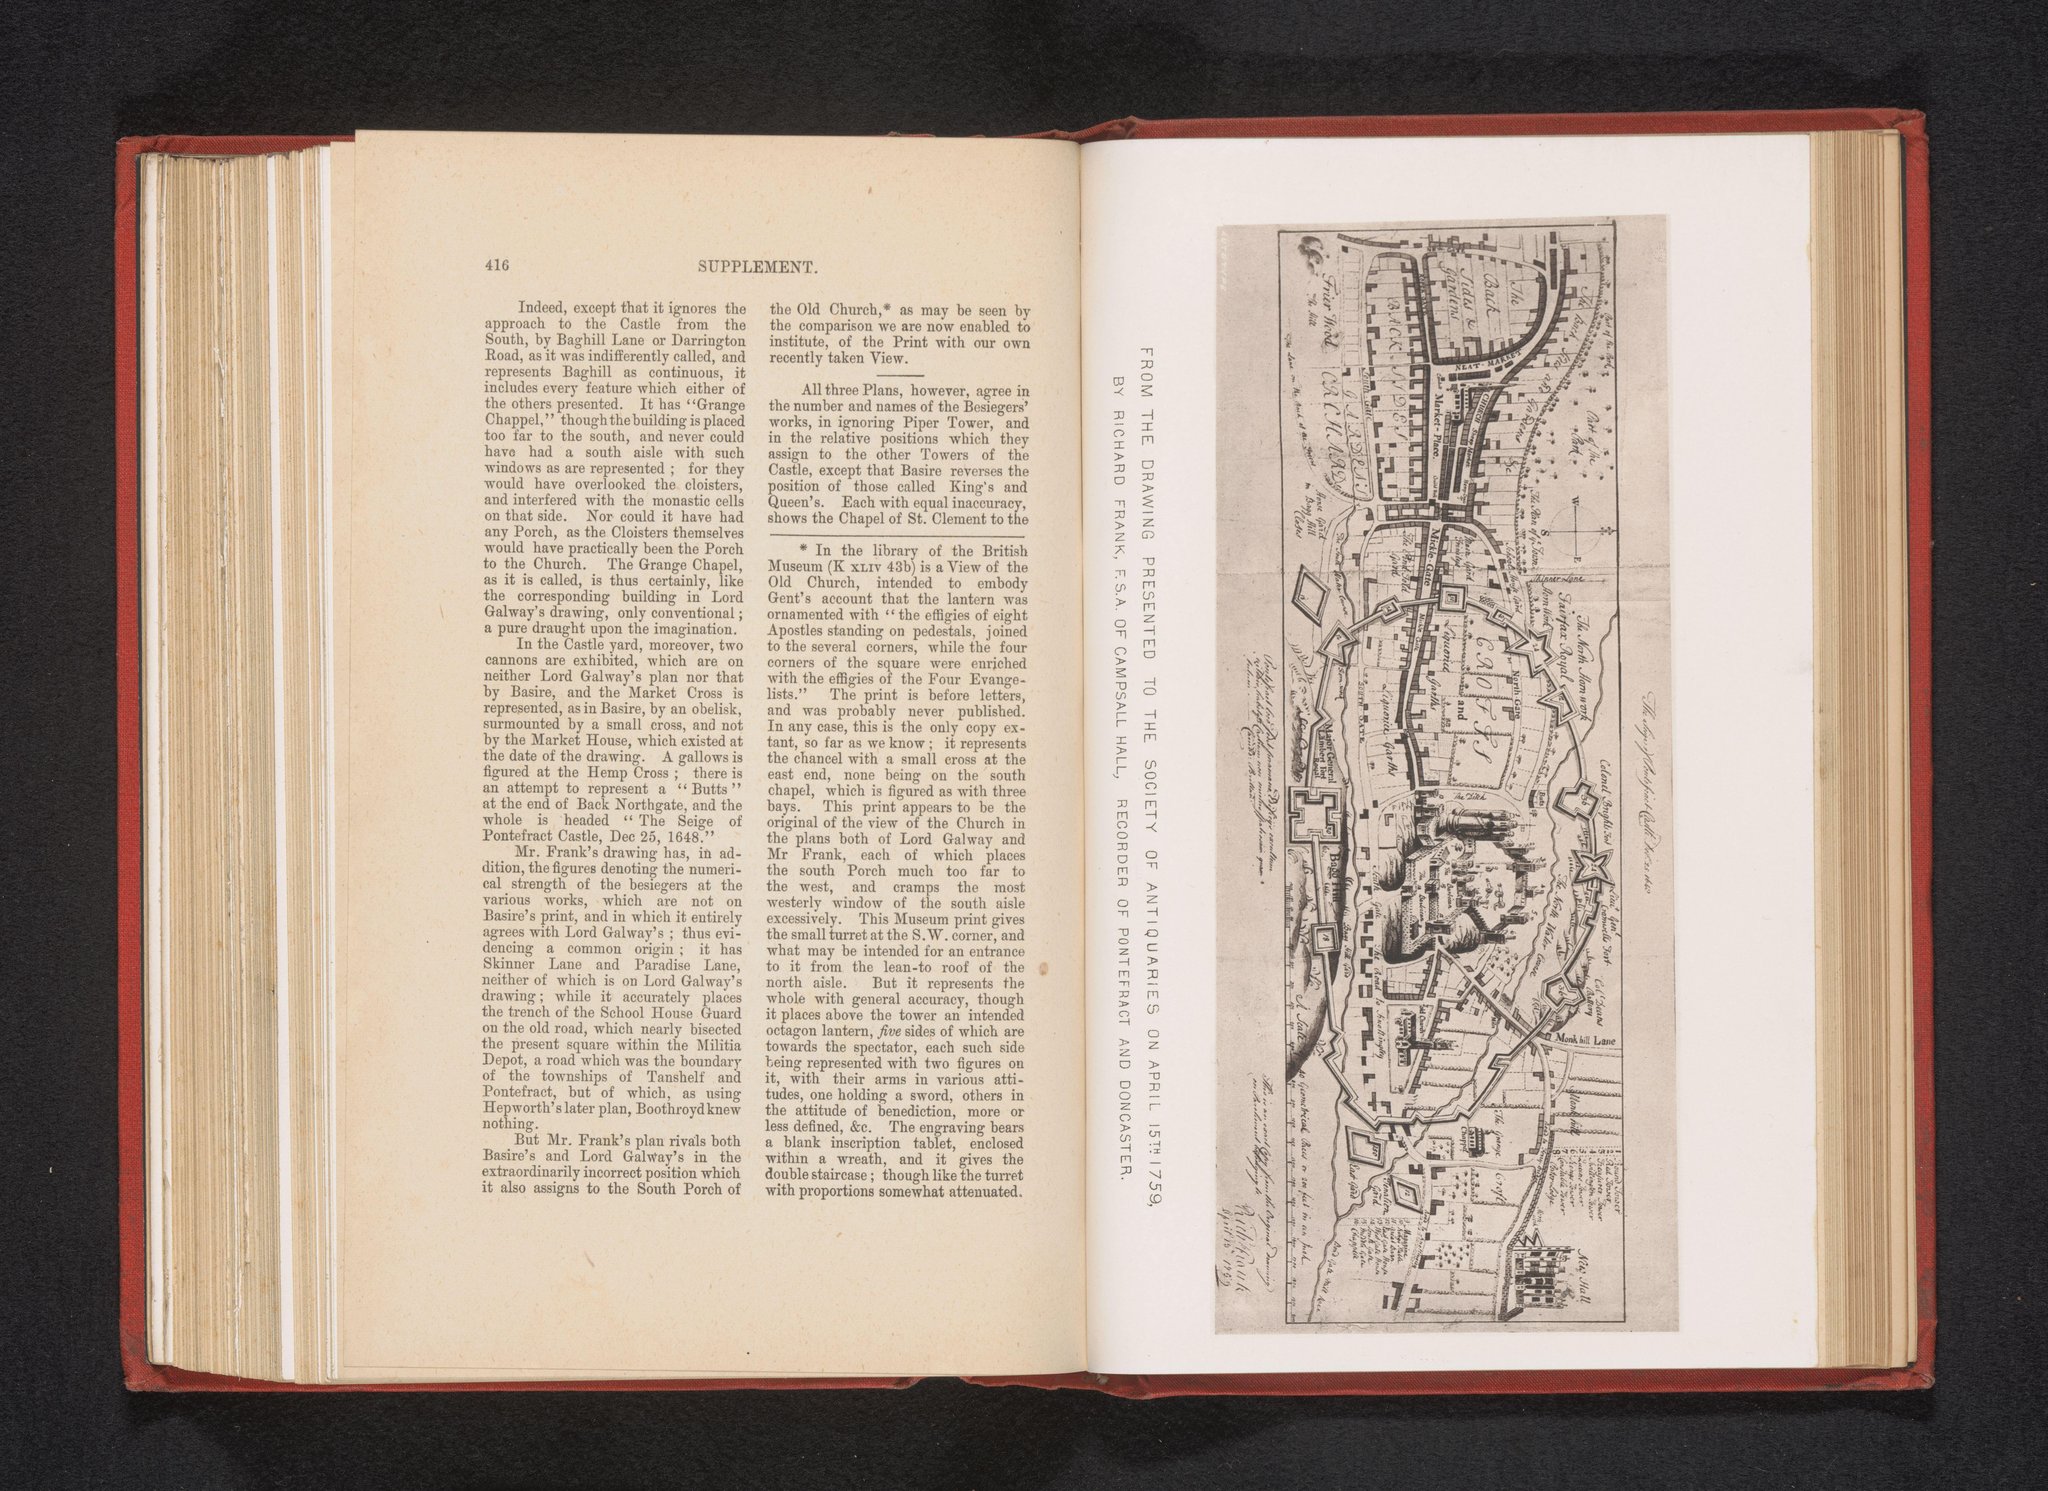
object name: photomechanical print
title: Reproductie van een kaart van Pontefract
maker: Anonymous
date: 1882-1887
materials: paper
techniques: photograph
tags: maps of cities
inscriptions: inscription: ‘From the drawing presented to the society of antiquaries on April 15th 1759,/ by Richard Frank, F.S.A. of Campsall Hall, recorder of Pontefract and Doncaster.’